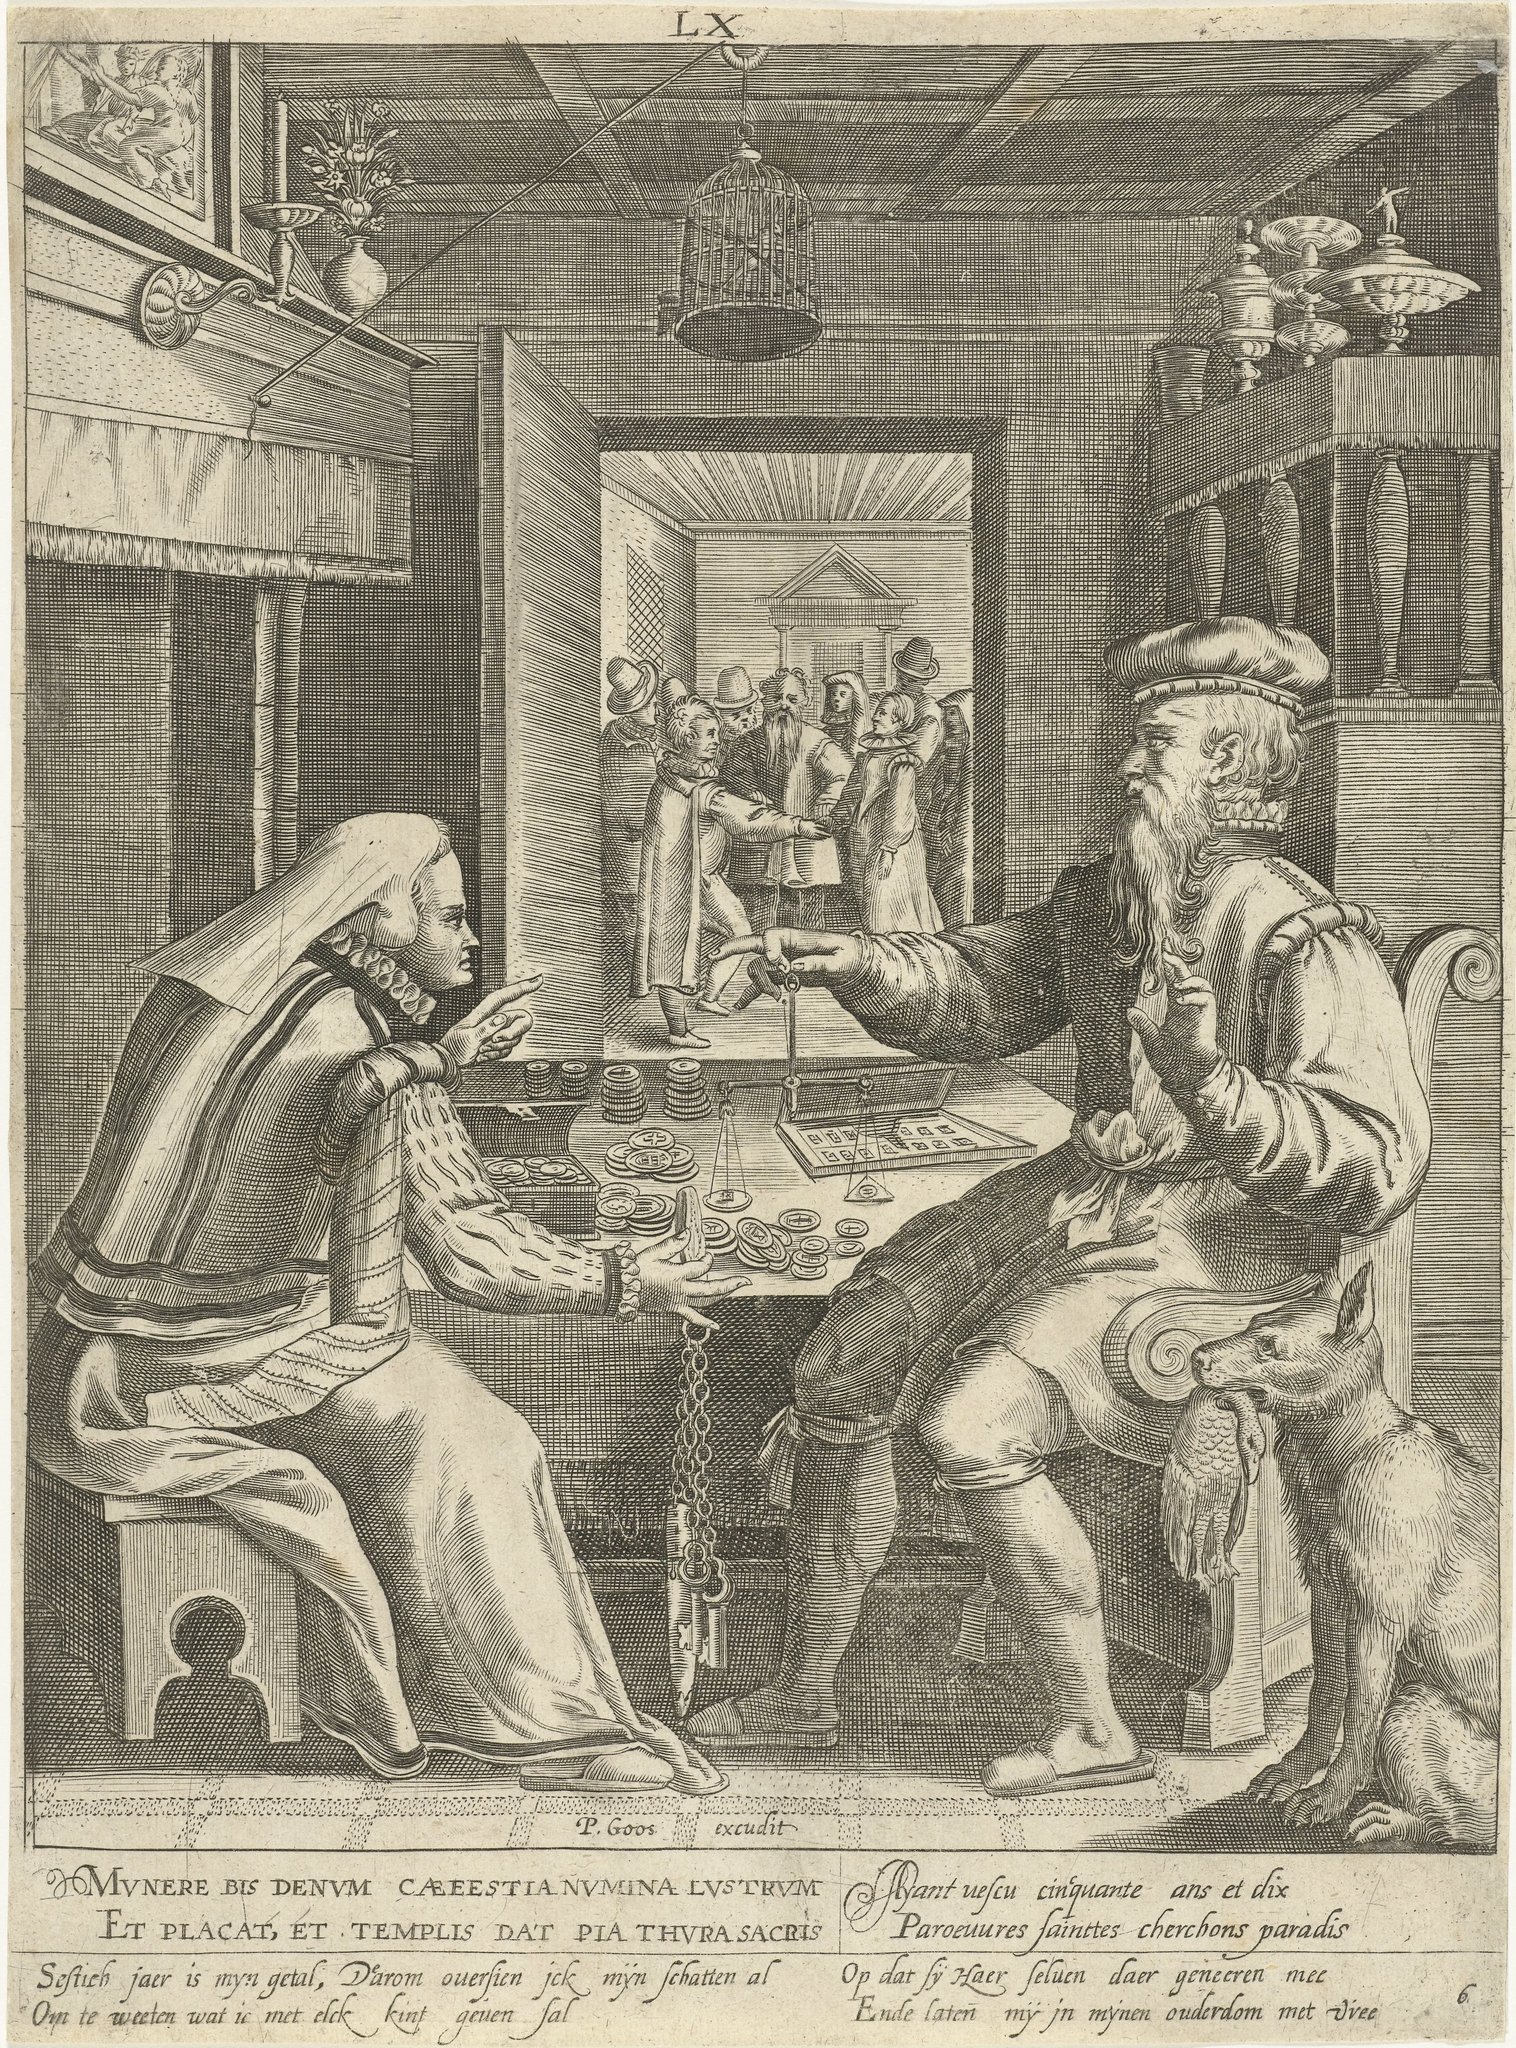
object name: print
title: LX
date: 1598-1602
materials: paper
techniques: engraving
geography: netherlands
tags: weighing gold or money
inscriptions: collector's mark: Lugt 2228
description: Prent naar ontwerp van Nicolaes de Bruyn. Prent uit serie van tien prenten met de tien levensfasen. Zie voor uitgebreide documentatie bij Janssen 2007, p. 129-174. De Hoop Scheffer beschrijft drie uitgaven, ze noemt de uitgave van Pieter Goos als tweede (De Hoop Scheffer 1996, p. 290).